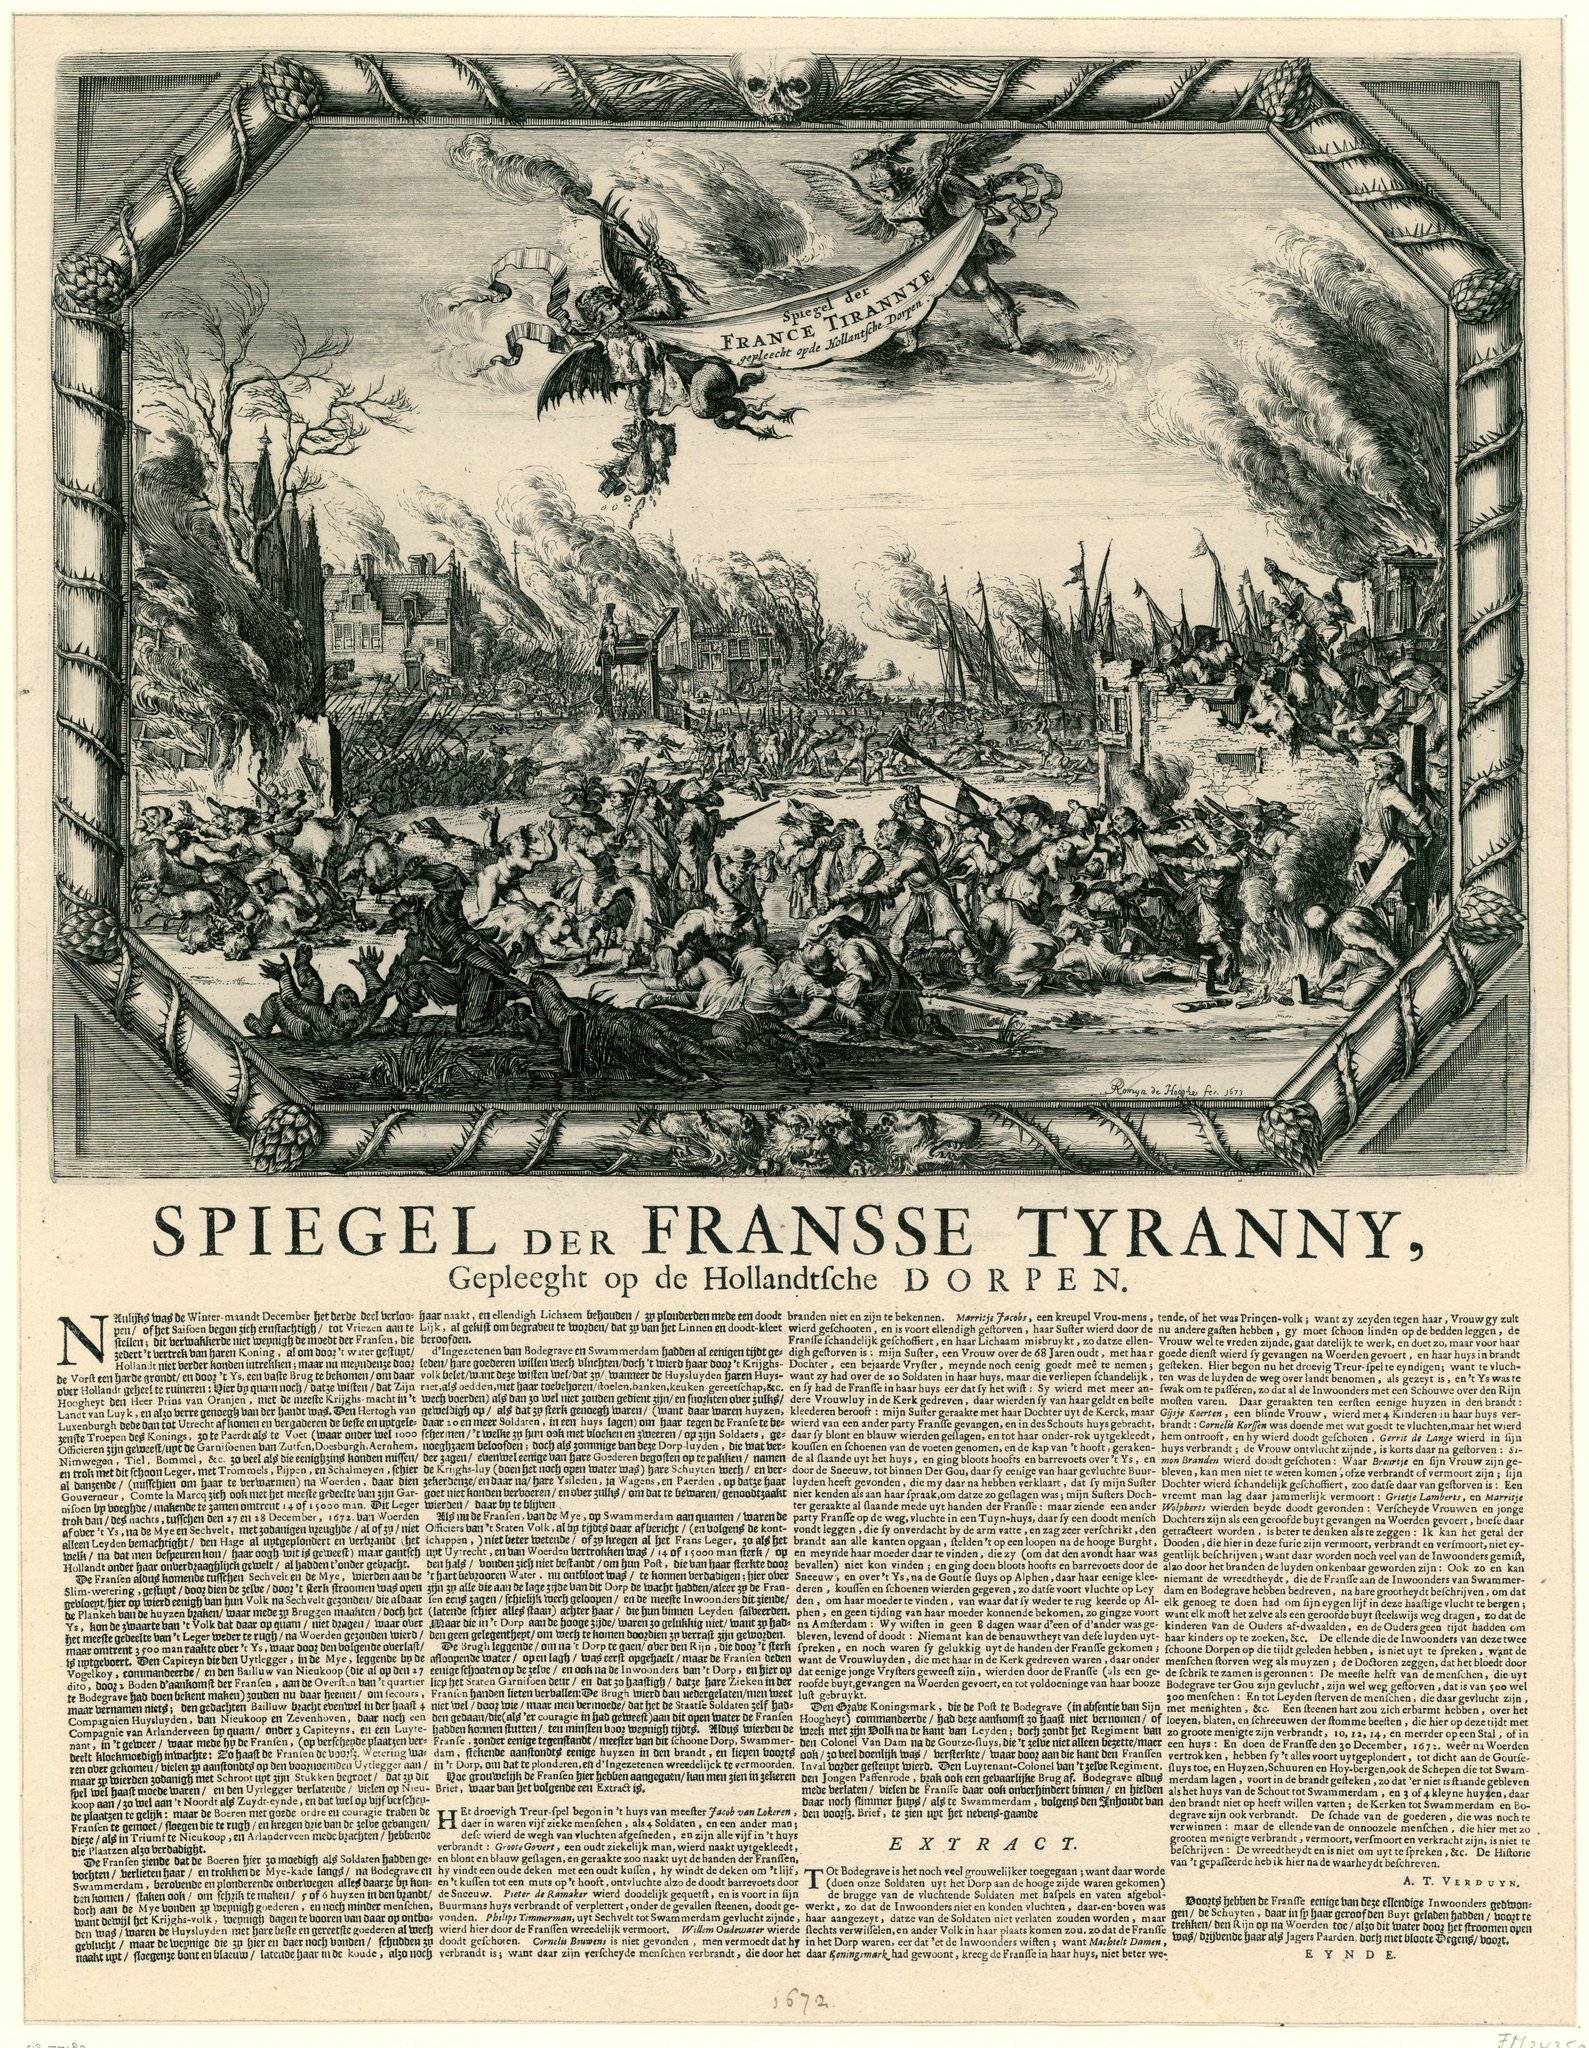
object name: print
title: Spiegel der Fransse Tyranny, Gepleeght op de Hollandtsche Dorpen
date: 1673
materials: paper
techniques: engraving, etching, letterpress printing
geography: northern netherlands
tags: rape, violation, plundering ~ soldiers, violent death, being killed; being mishandled and maltreated; seeking death, massacre ~ war, bodegraven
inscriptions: date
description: Voorstelling van de wreedheden gepleegd door de Franse troepen in de Hollandse dorpen Bodegraven en Zwammerdam, eind december 1672. Het opschrift wordt in de lucht gedragen door personificaties van de oorlog en de Franse wreedheid. Links het brandende dorp Zwammerdam met de ophaalbrug. Op de voorgrond verkrachtingen, martelingen en moordpartijen. De voorstelling is gevat in een octogonale lijst, omwonden door doornen en bekroond met een doodshoofd. Onder de voorstelling staat een beschrijving van de gebeurtenissen over vier kolommen in het Nederlands. Een deel van deze beschrijving, het 'Extract', is geschreven door A.T. Verduyn.